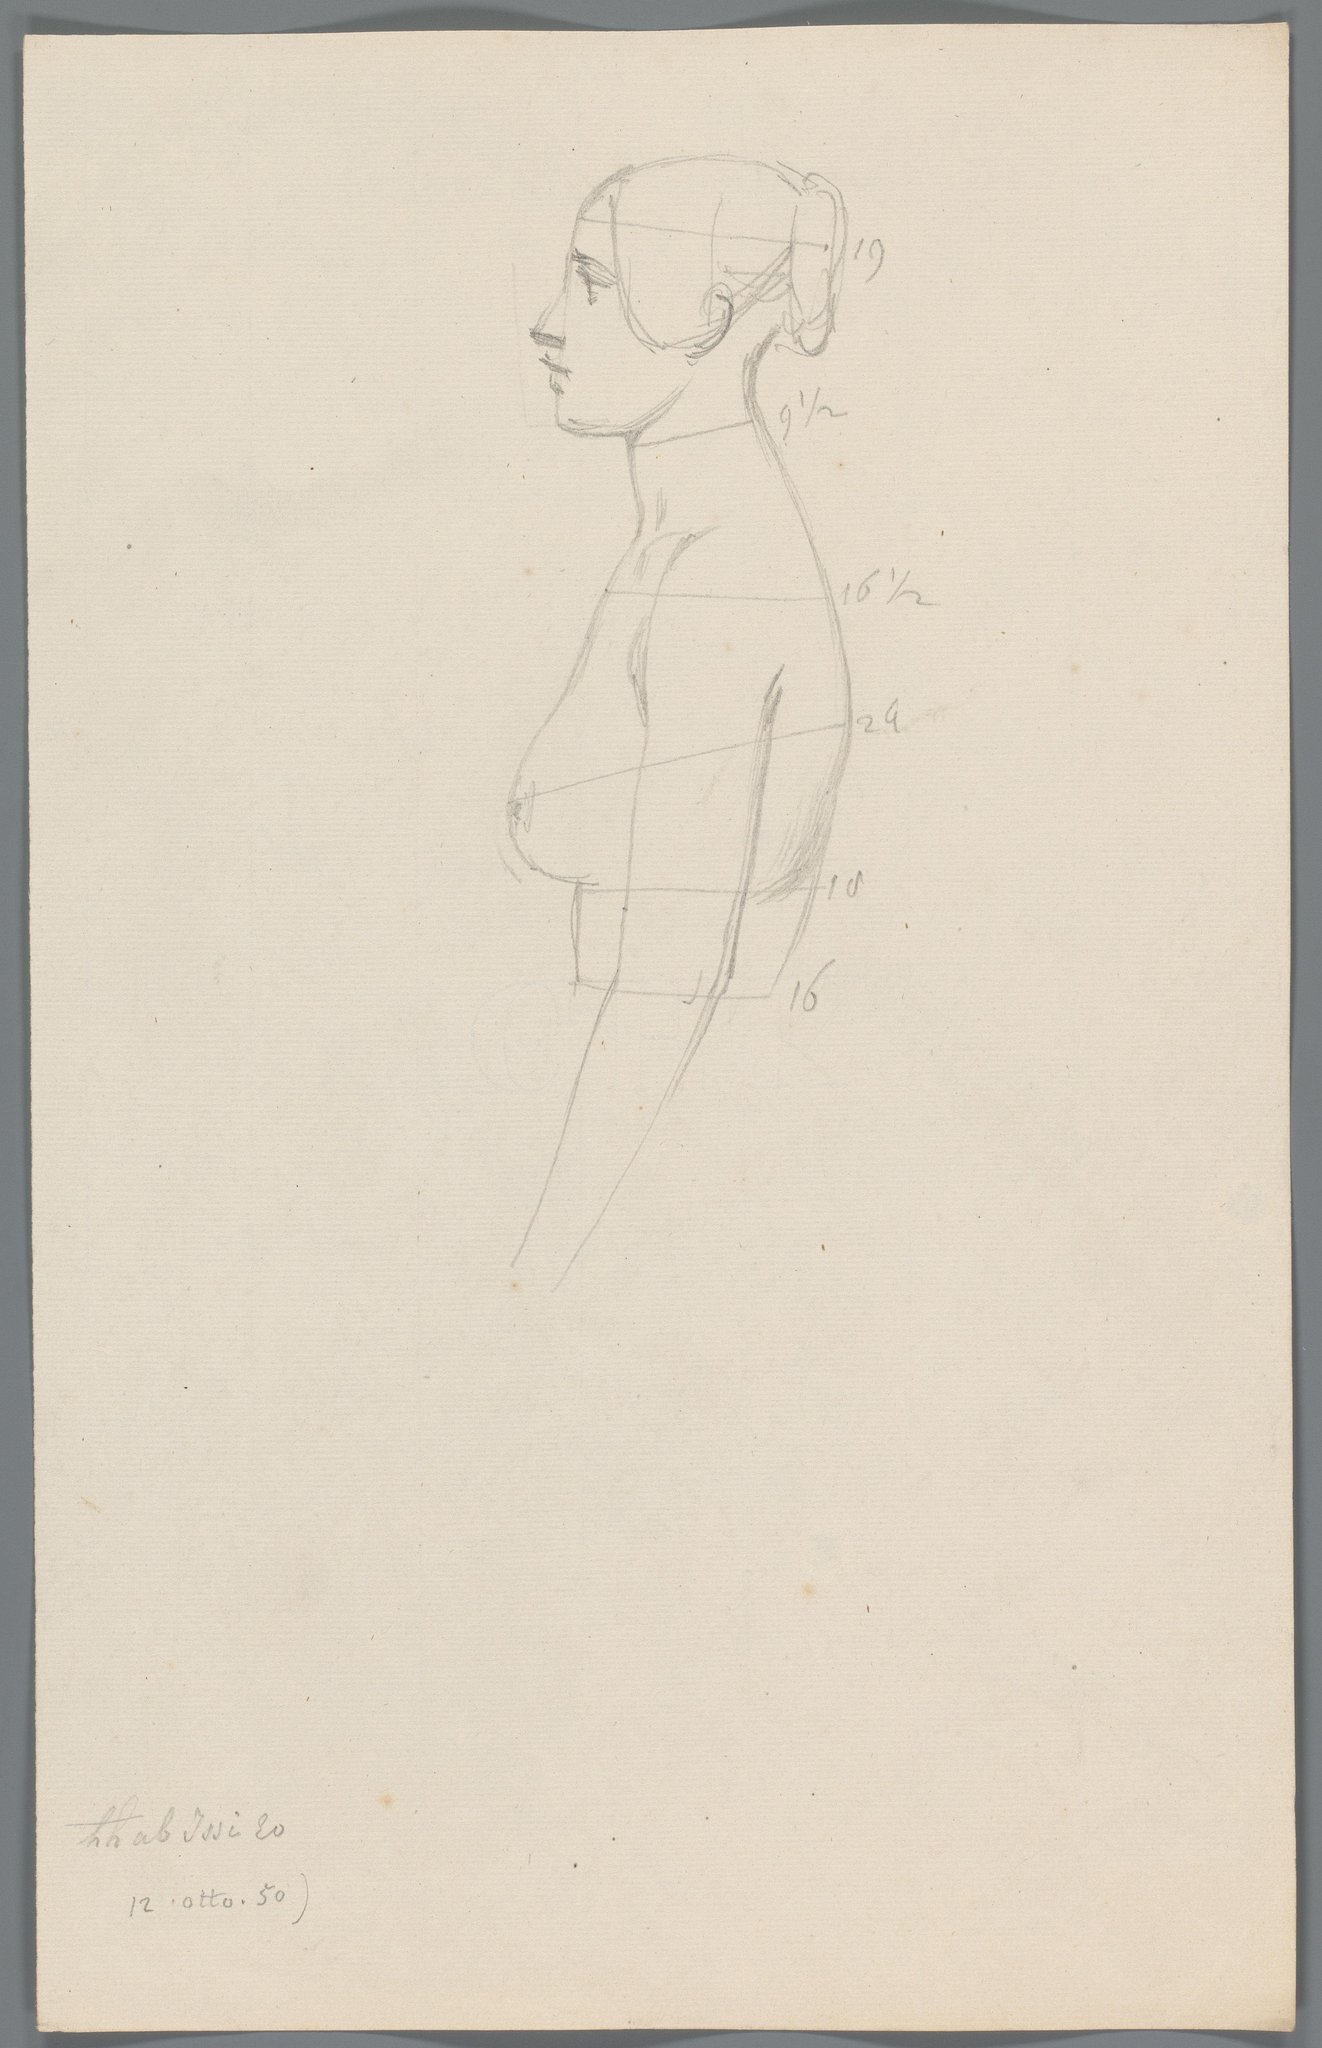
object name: drawing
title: Proportiestudie van een vrouw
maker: jacobus everhardus josephus van den berg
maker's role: draughtsman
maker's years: 1802-1861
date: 1850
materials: paper, pencil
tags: standing figure (canon, proportions) - aa - female human figure, the (nude) human figure; 'corpo humano' (ripa) - aa - female human figure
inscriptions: inscription: ‘hhab Issi eo/ 12 otto 50’